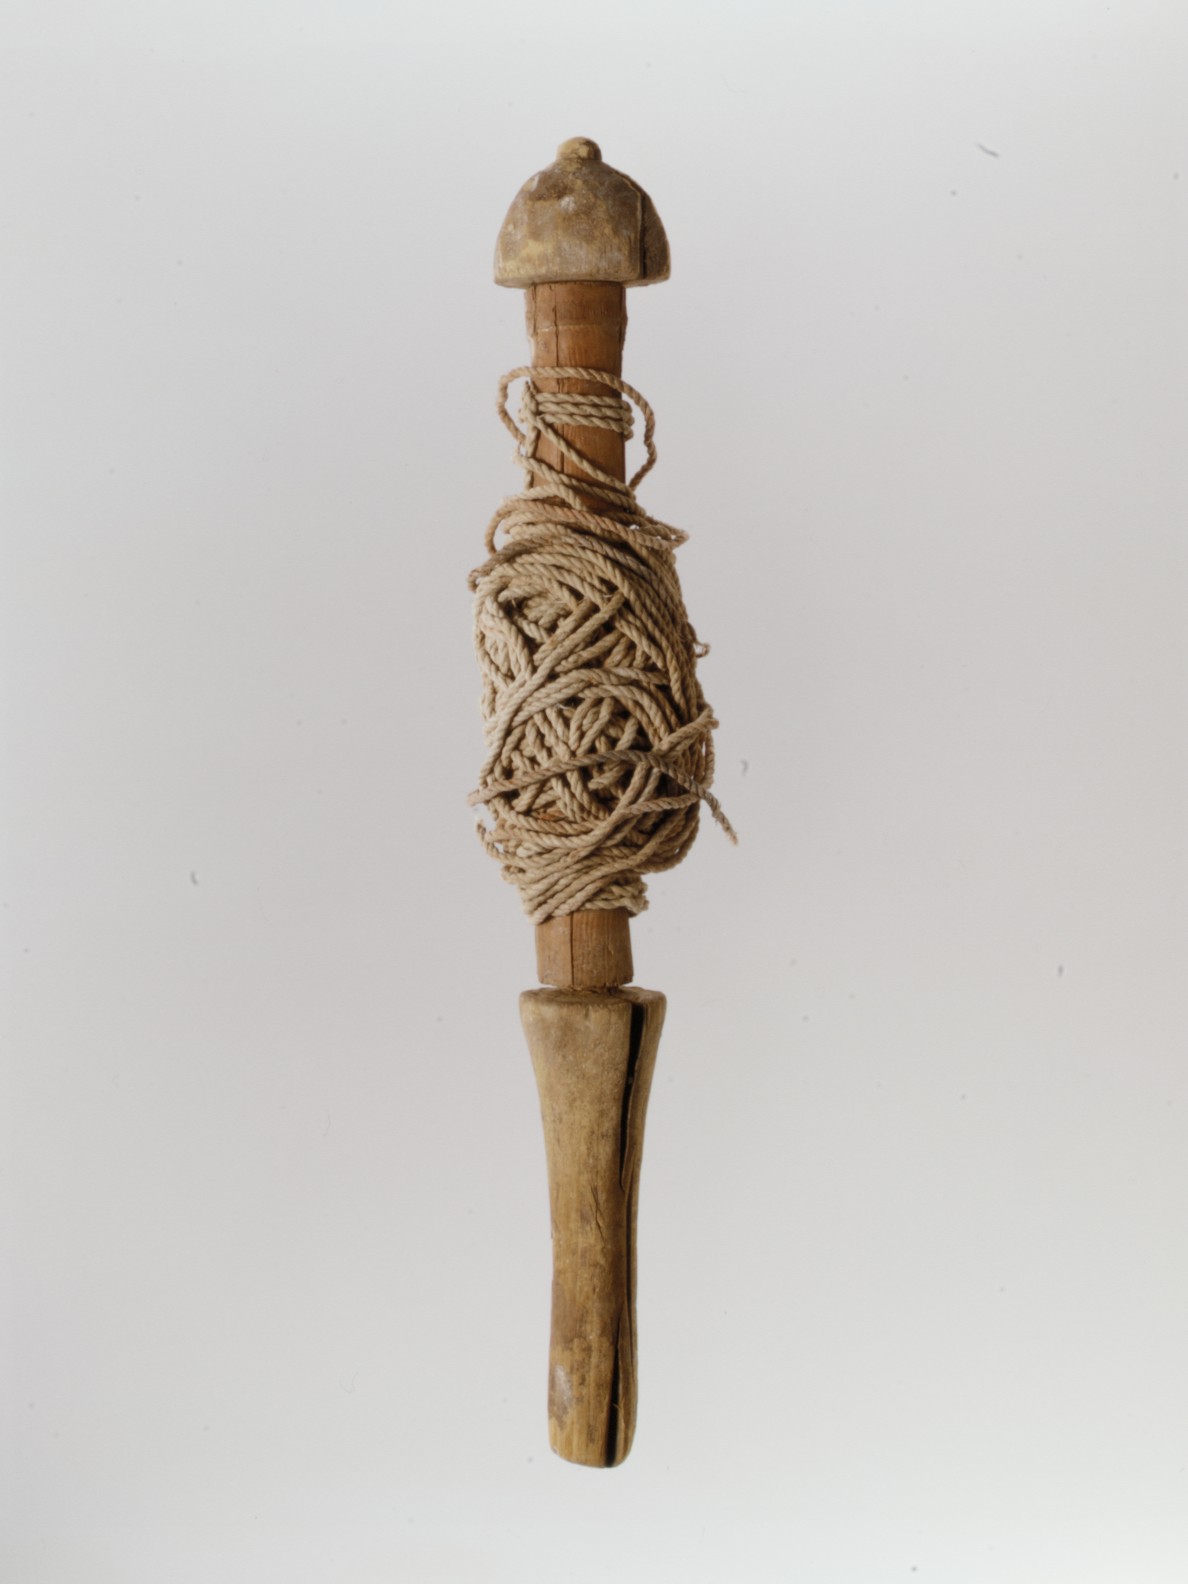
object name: builder's reel, cord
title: Builder's reel and cord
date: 2124-1504 BCE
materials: cord, linen, paint, wood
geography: egypt